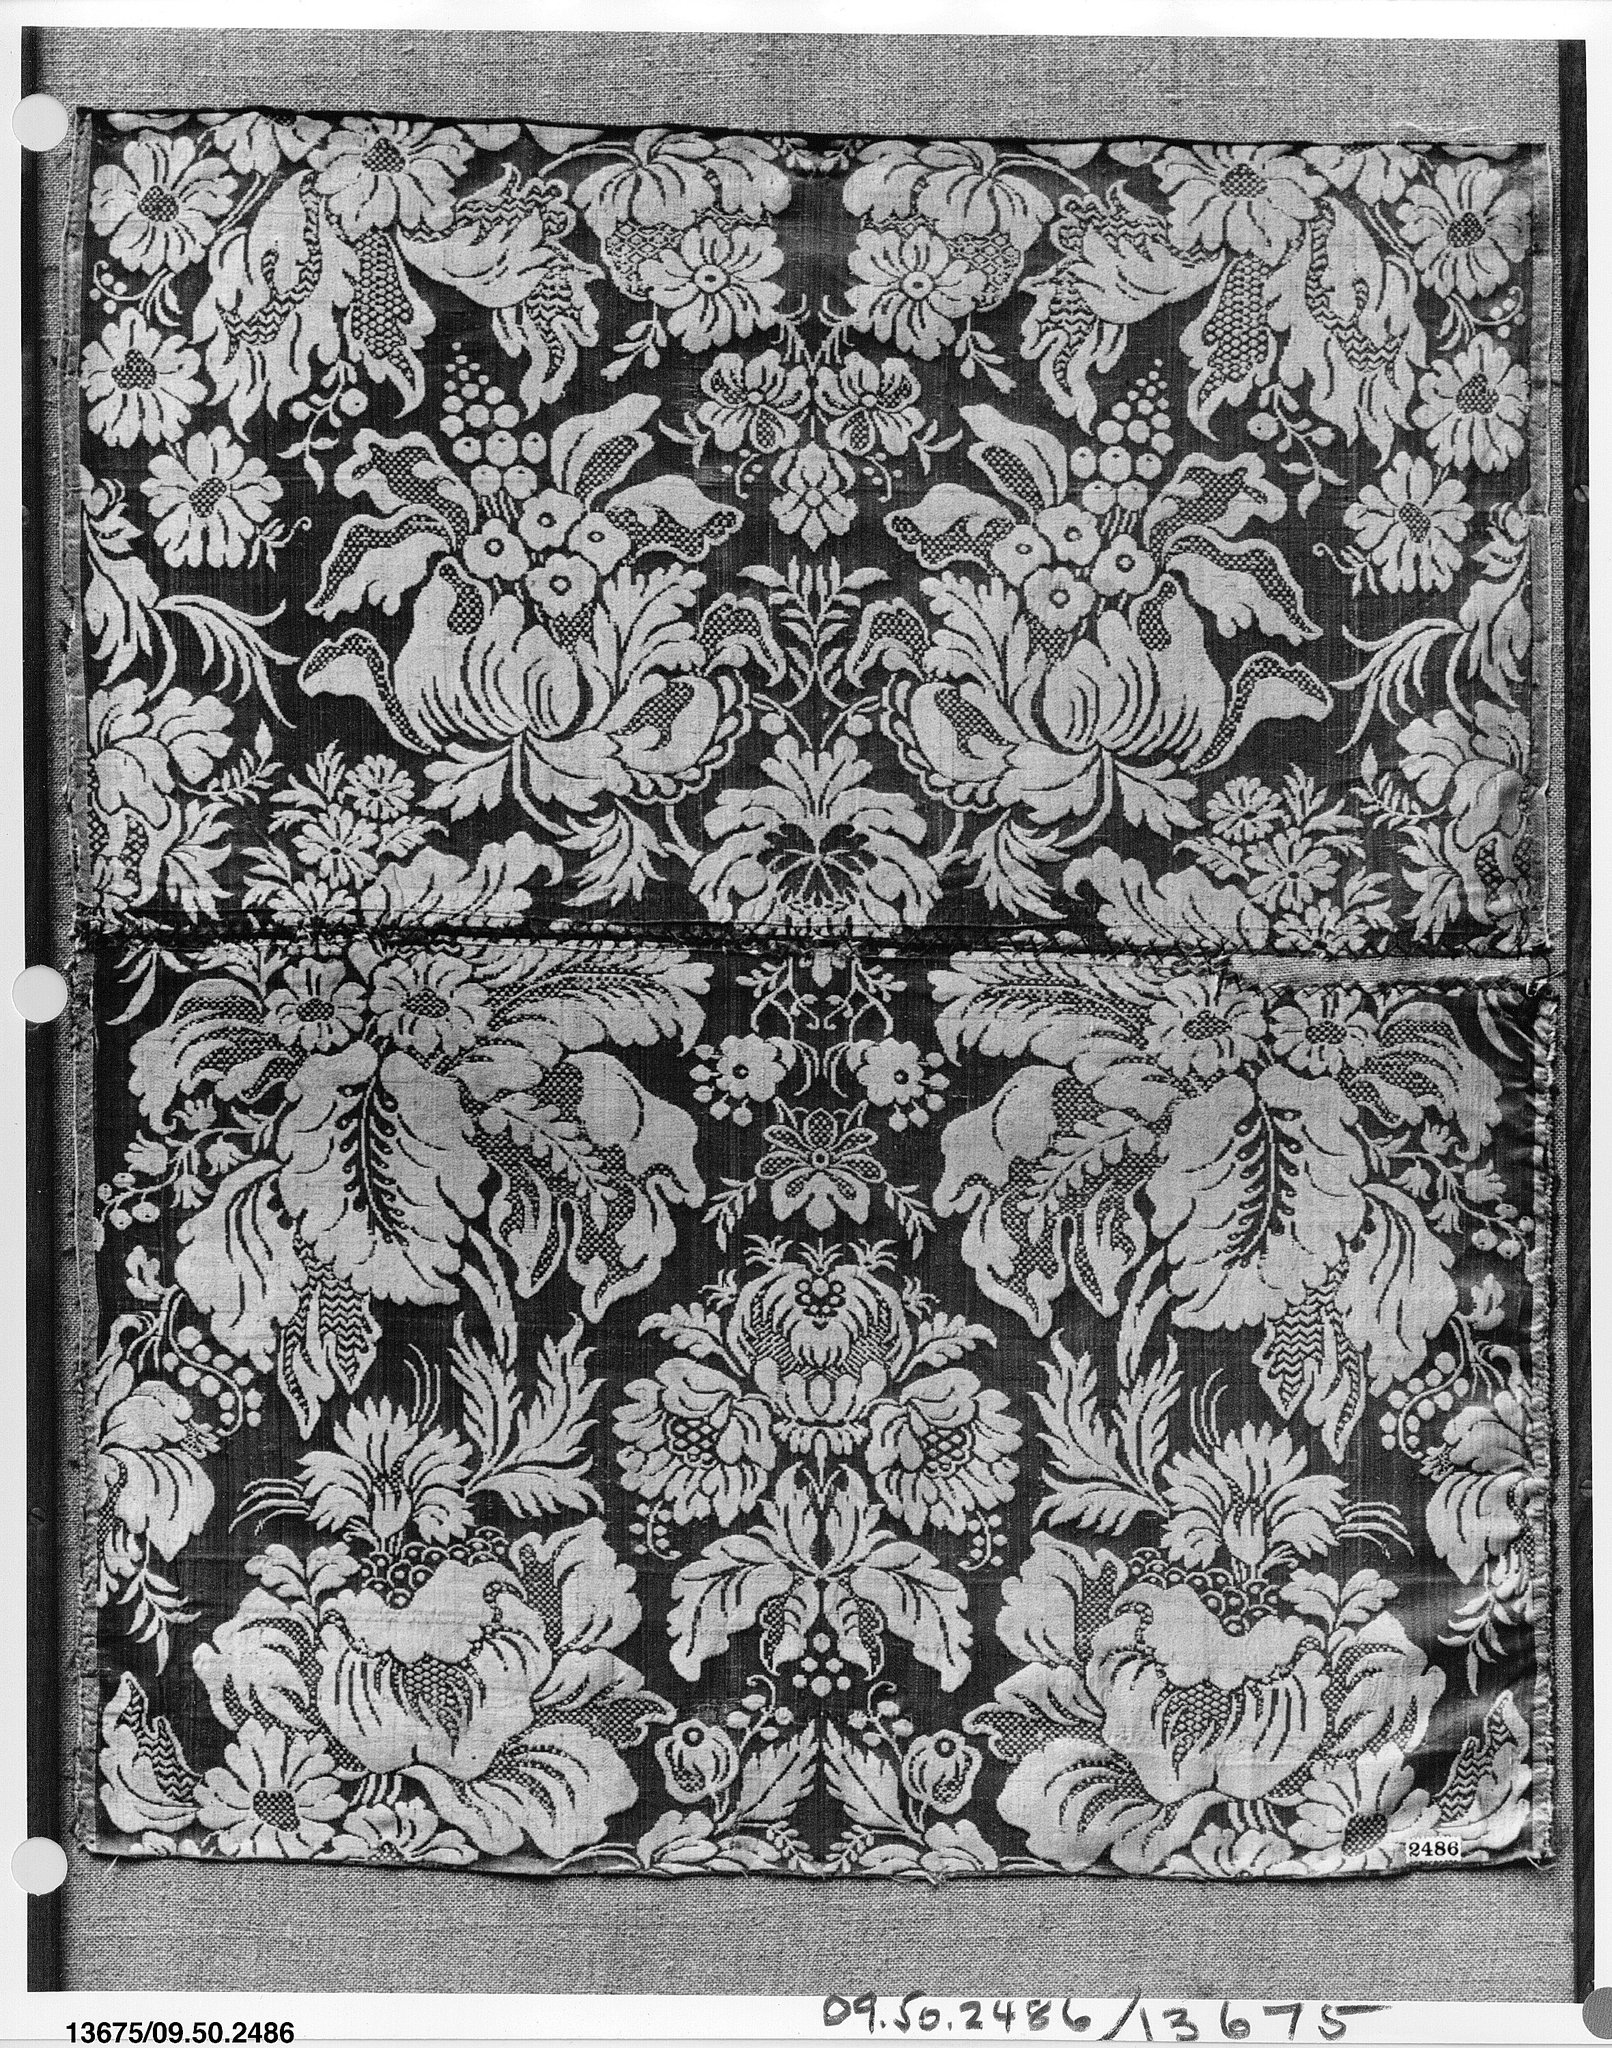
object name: piece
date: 1735-1750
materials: silk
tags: flowers,leaves